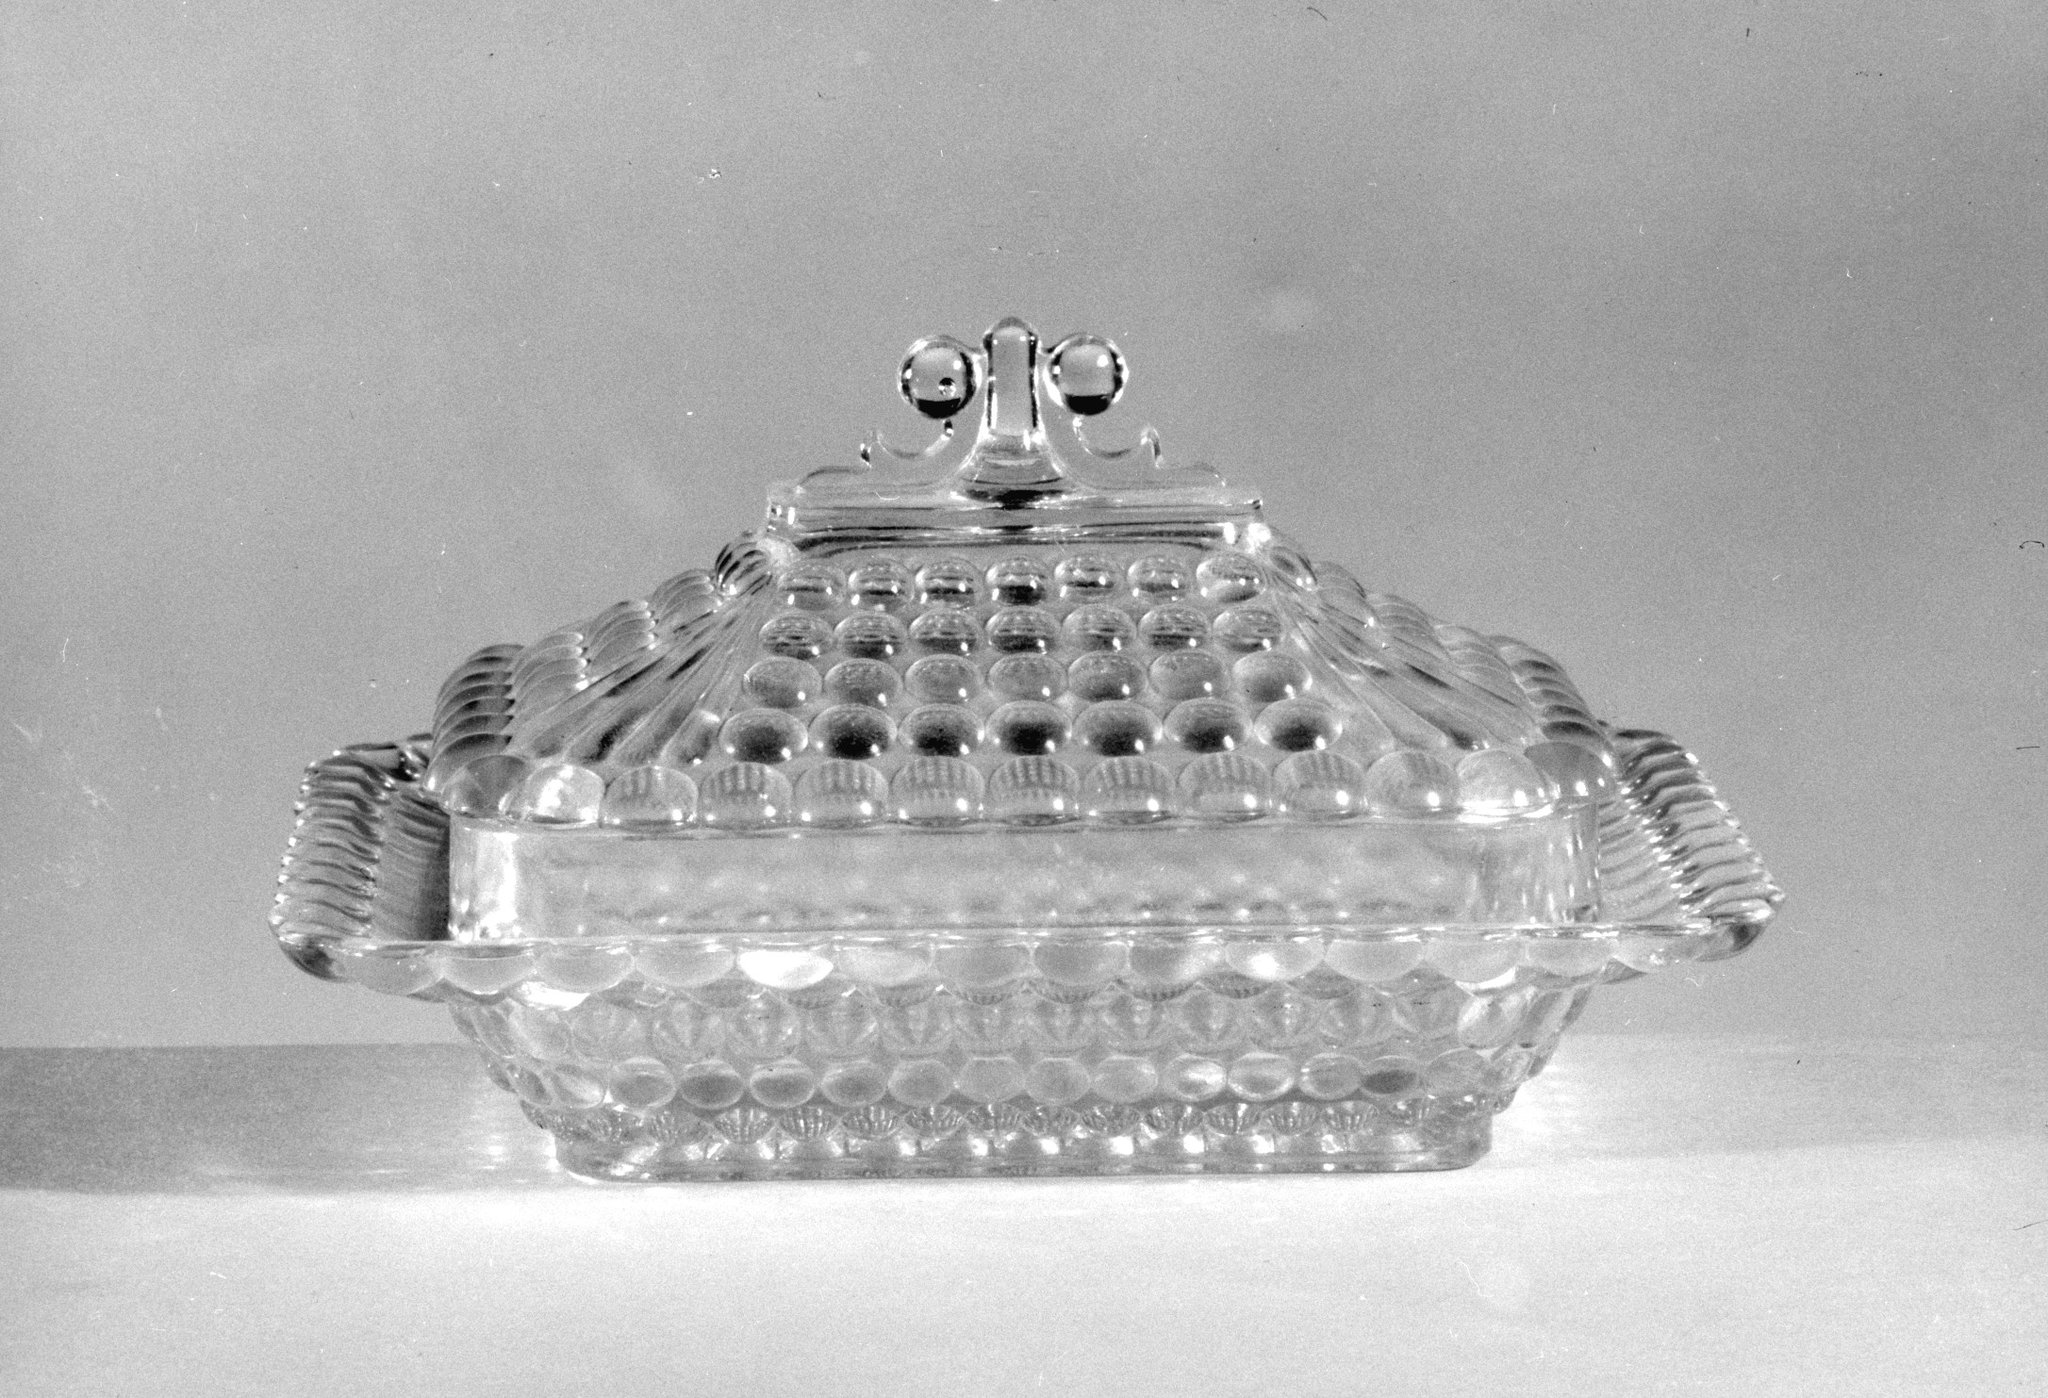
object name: honey dish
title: Covered Honey Dish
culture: american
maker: adams and company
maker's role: maker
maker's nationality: american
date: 1870-1890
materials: glass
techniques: pressed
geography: united states